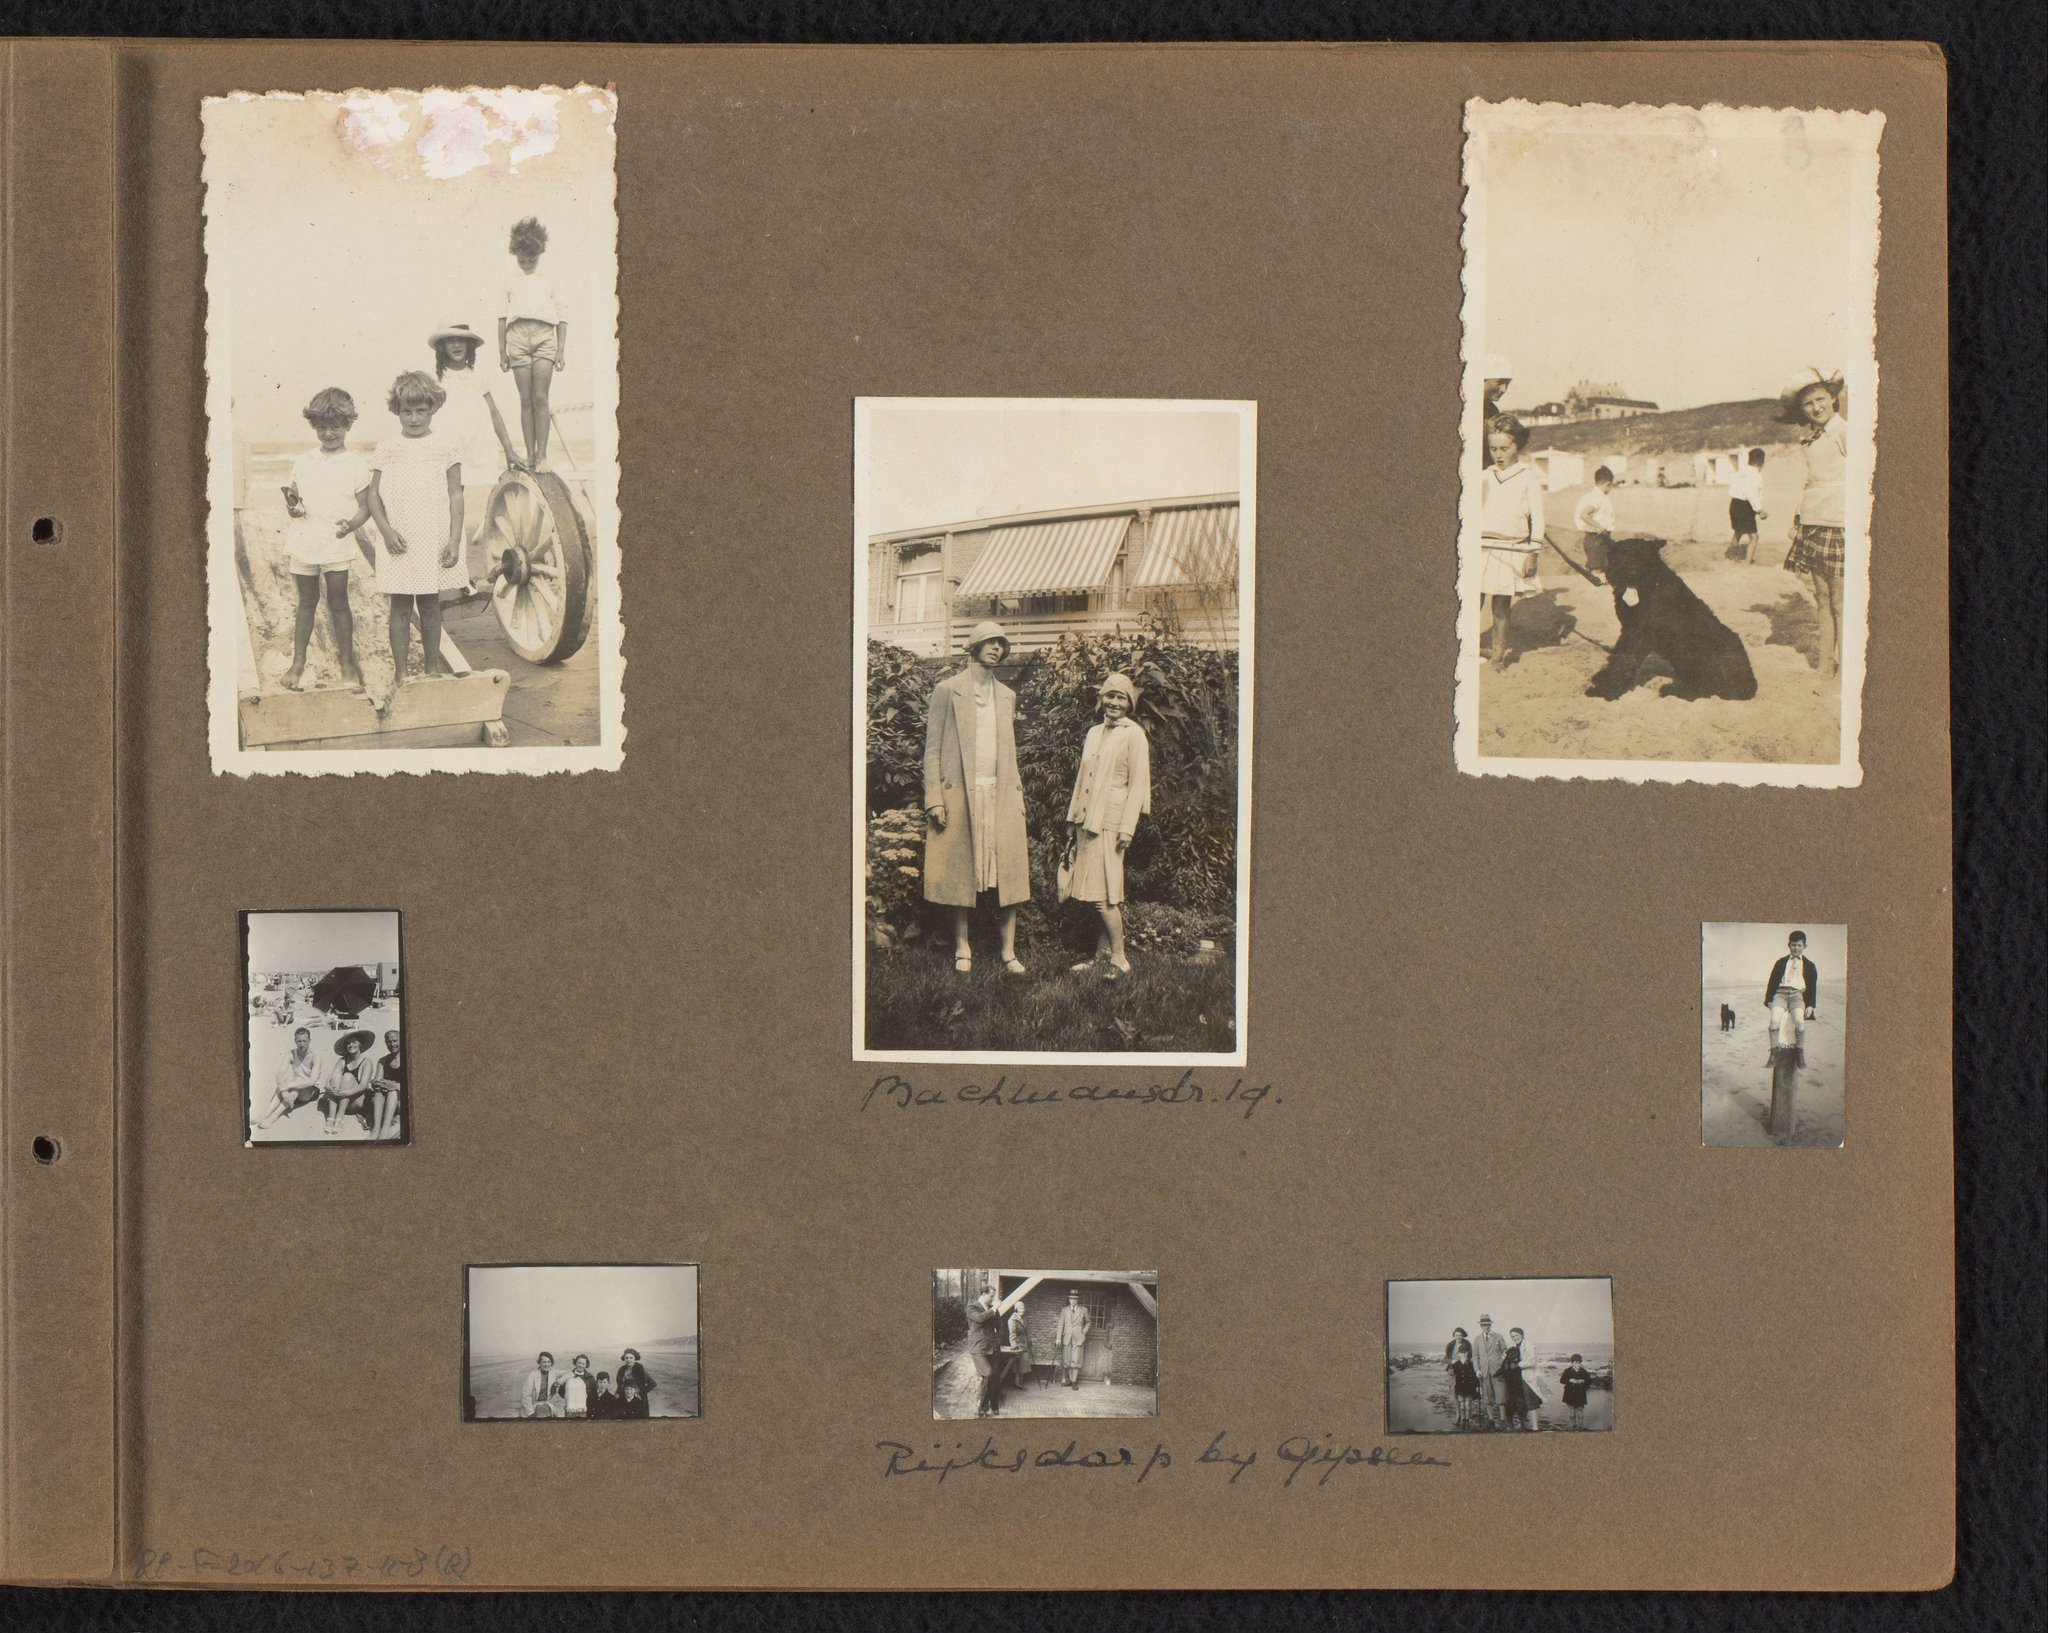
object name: photograph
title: Loentje Furnée met vrienden en kinderen op een strand en in een dorp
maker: carolina frederika onnen (lien/loen)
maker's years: 1896-1983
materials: paper, cardboard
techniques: gelatin silver print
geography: netherlands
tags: beach (as place of recreation), netherlands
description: Deze foto's zijn onderdeel van een album.